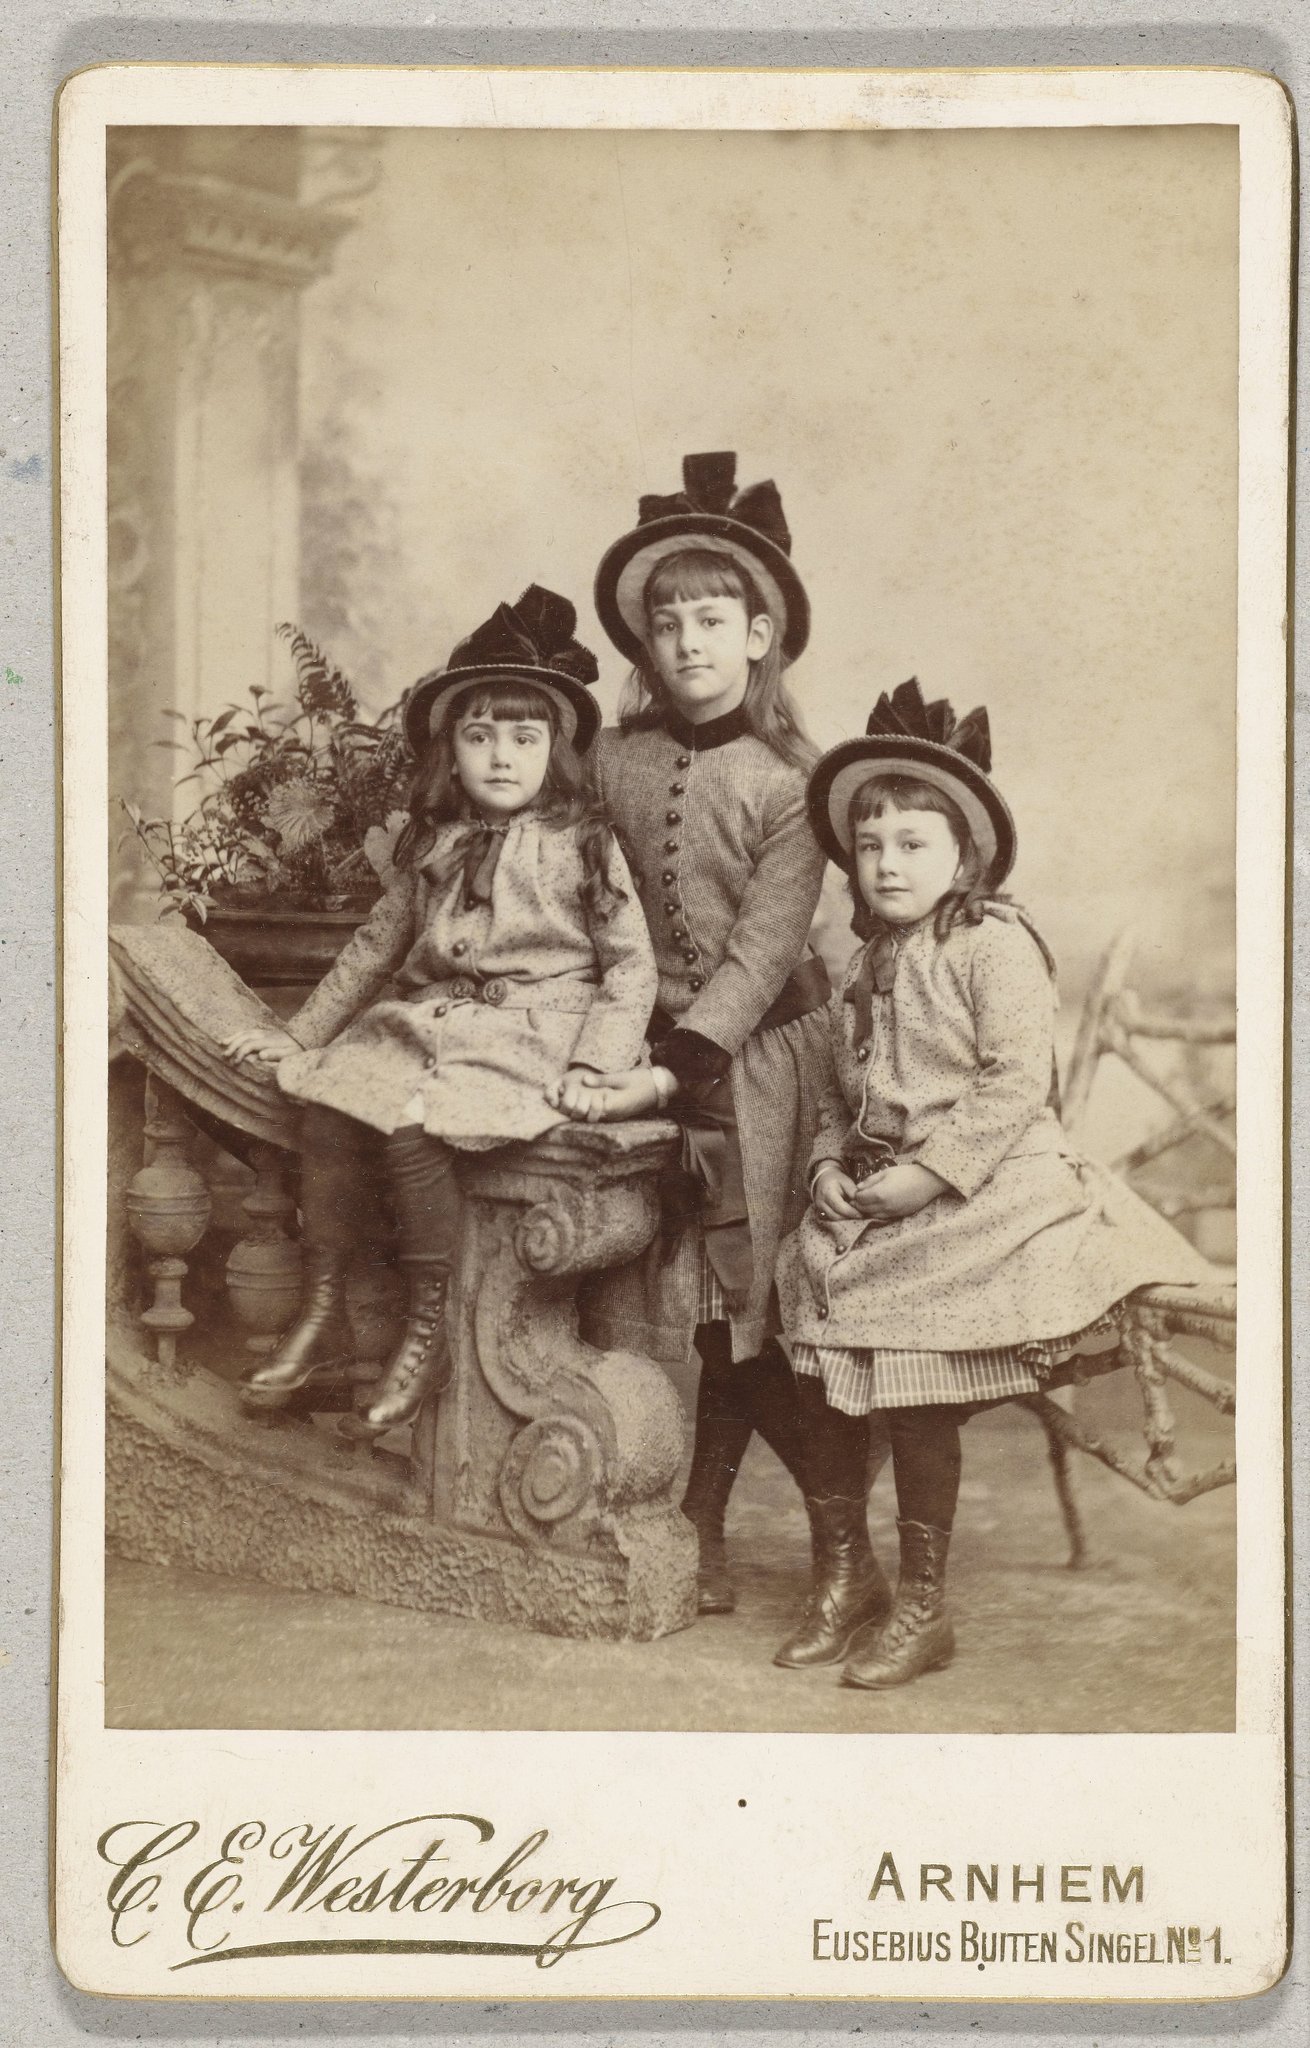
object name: photograph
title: Portret van Adeh, Ida en Kitty van Braam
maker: carel eduard westerborg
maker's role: fotograaf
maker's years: 1842-1916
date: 1880-1900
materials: cardboard, paper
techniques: albumen print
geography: arnhem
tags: historical person (with name) - bb - woman - historical person (with name) portrayed in a group, in a group-portrait, netherlands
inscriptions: signature: ‘C.E. Westerborg Arnhem Eusebius Buiten Singel no. 1’